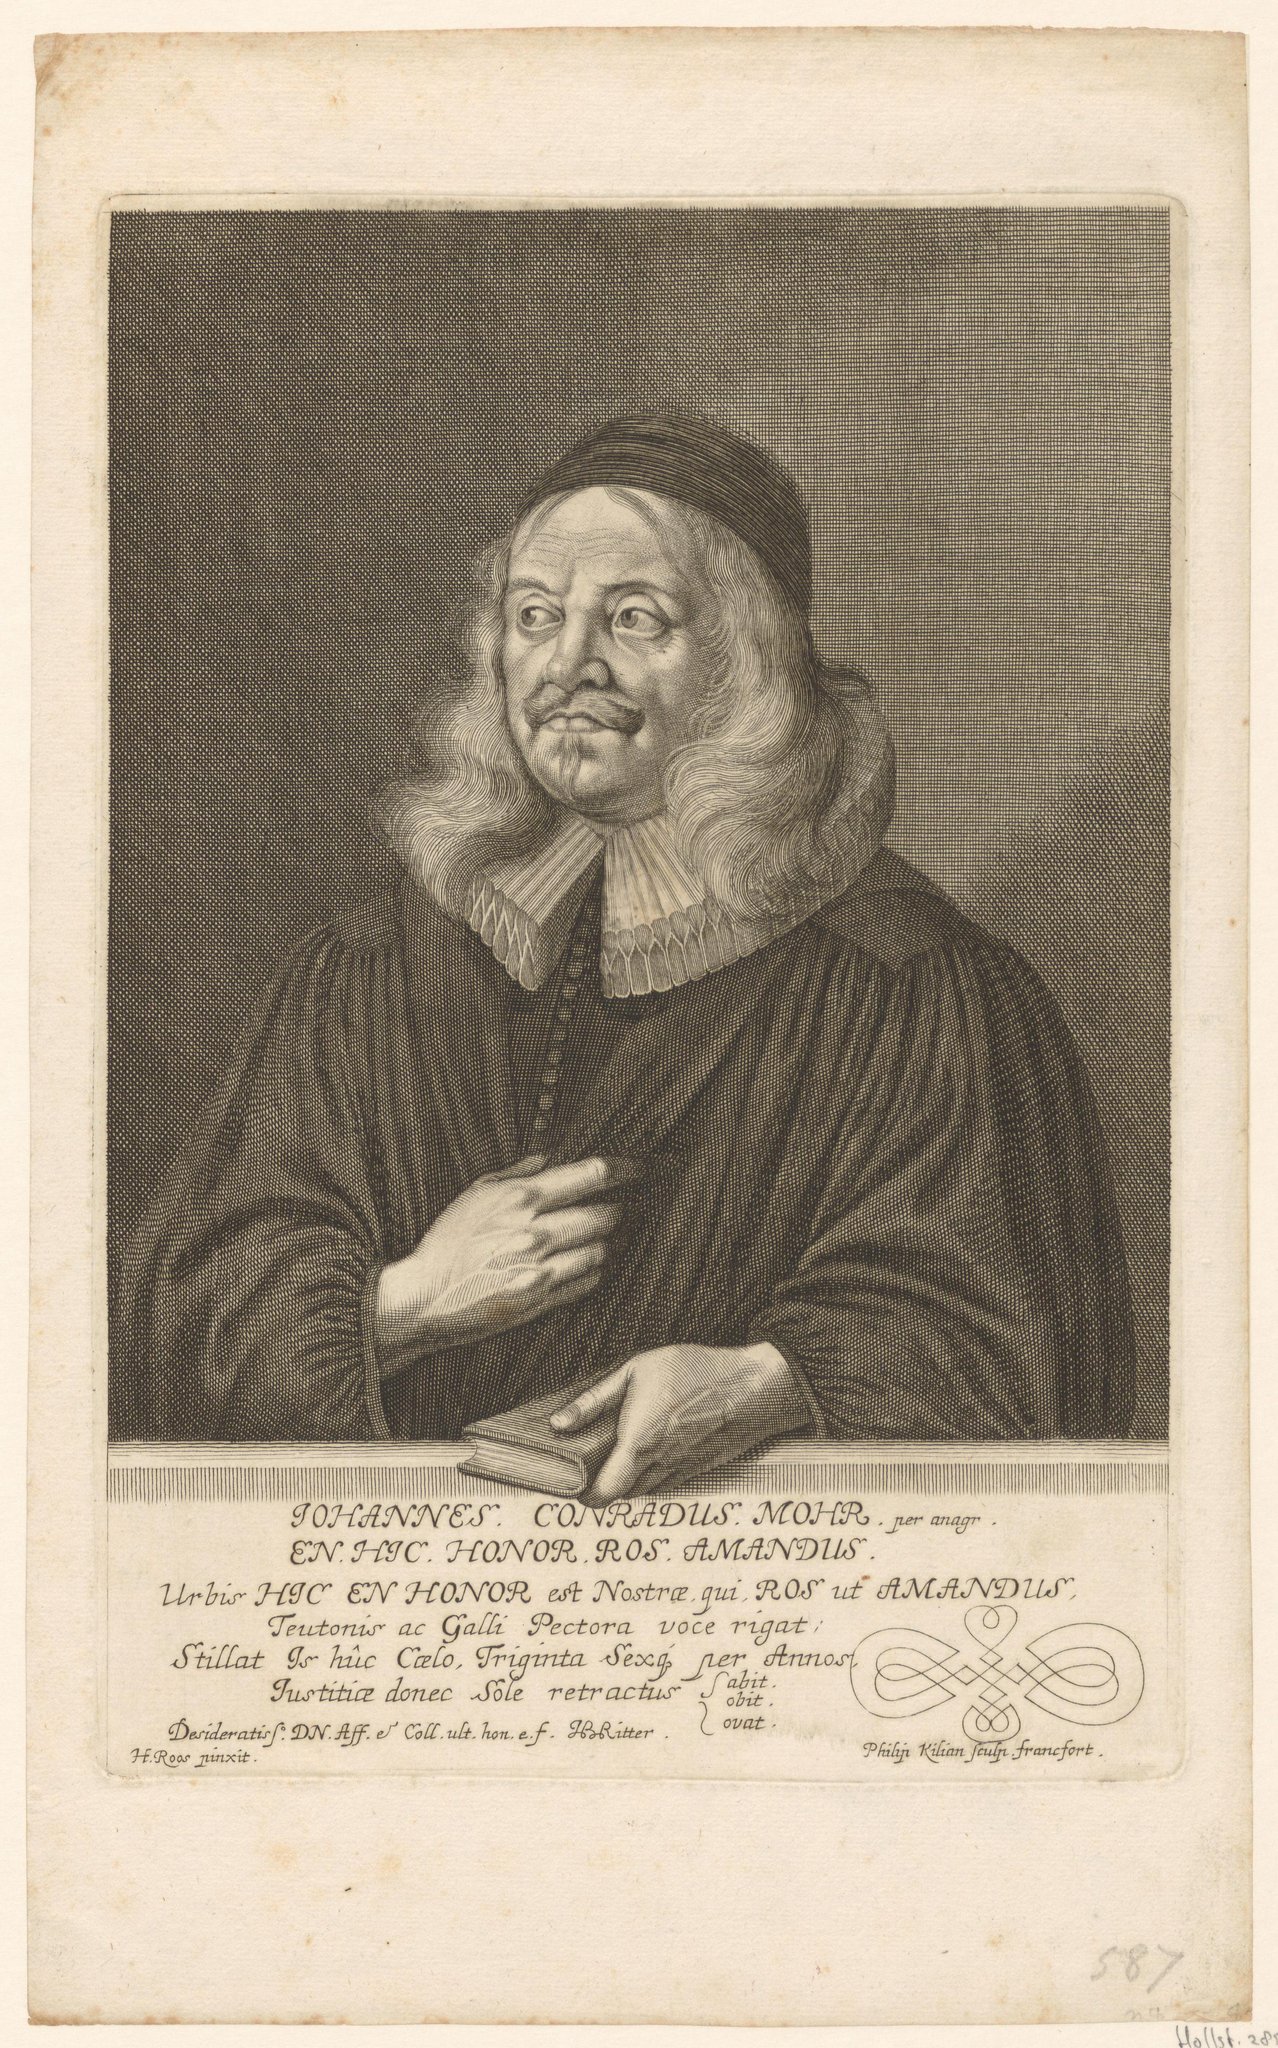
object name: print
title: Portret van Johann Conrad Mohr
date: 1671-1693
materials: paper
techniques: engraving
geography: frankfurt am main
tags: johann conrad mohr, theologian, historical persons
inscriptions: collector's mark: Lugt 2228